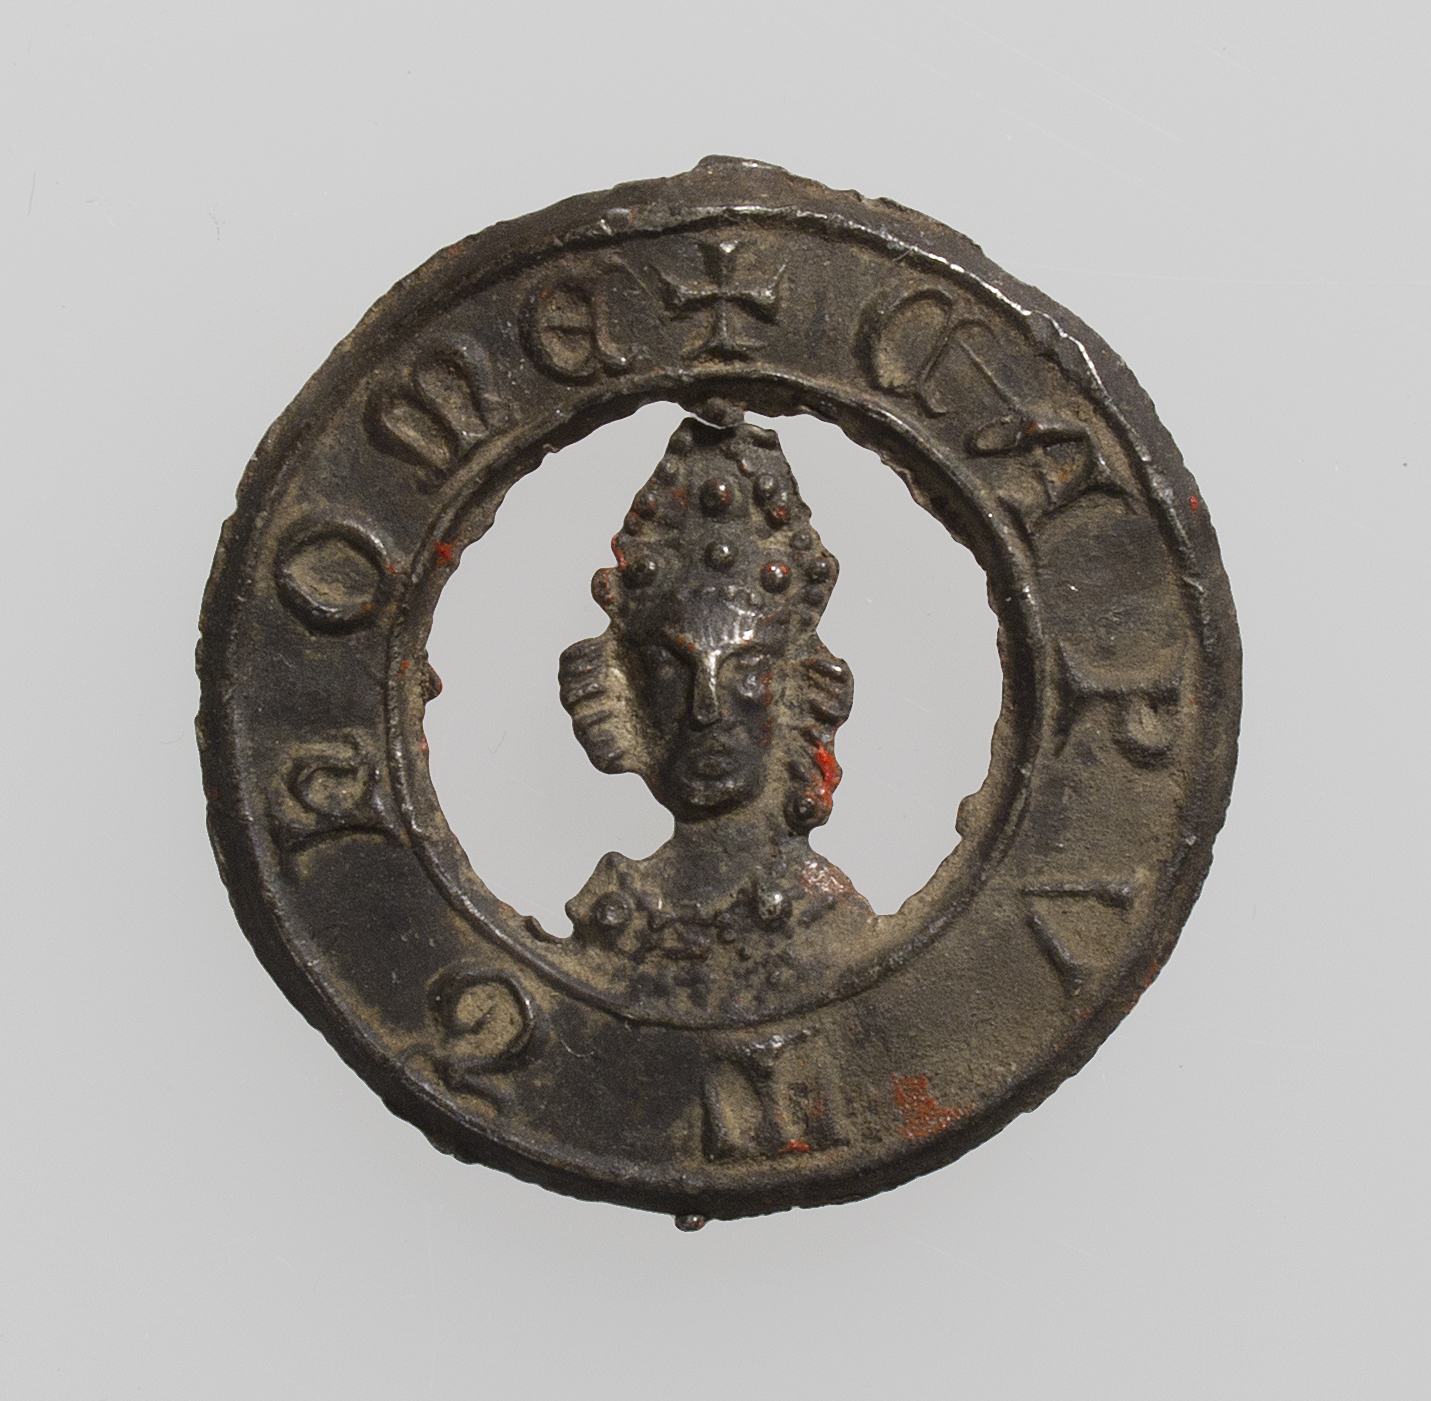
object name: pilgrim's badge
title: Pilgrim's Badge with head of Saint Thomas à Becket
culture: british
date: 1401-1500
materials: alloy, lead, tin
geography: england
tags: saints